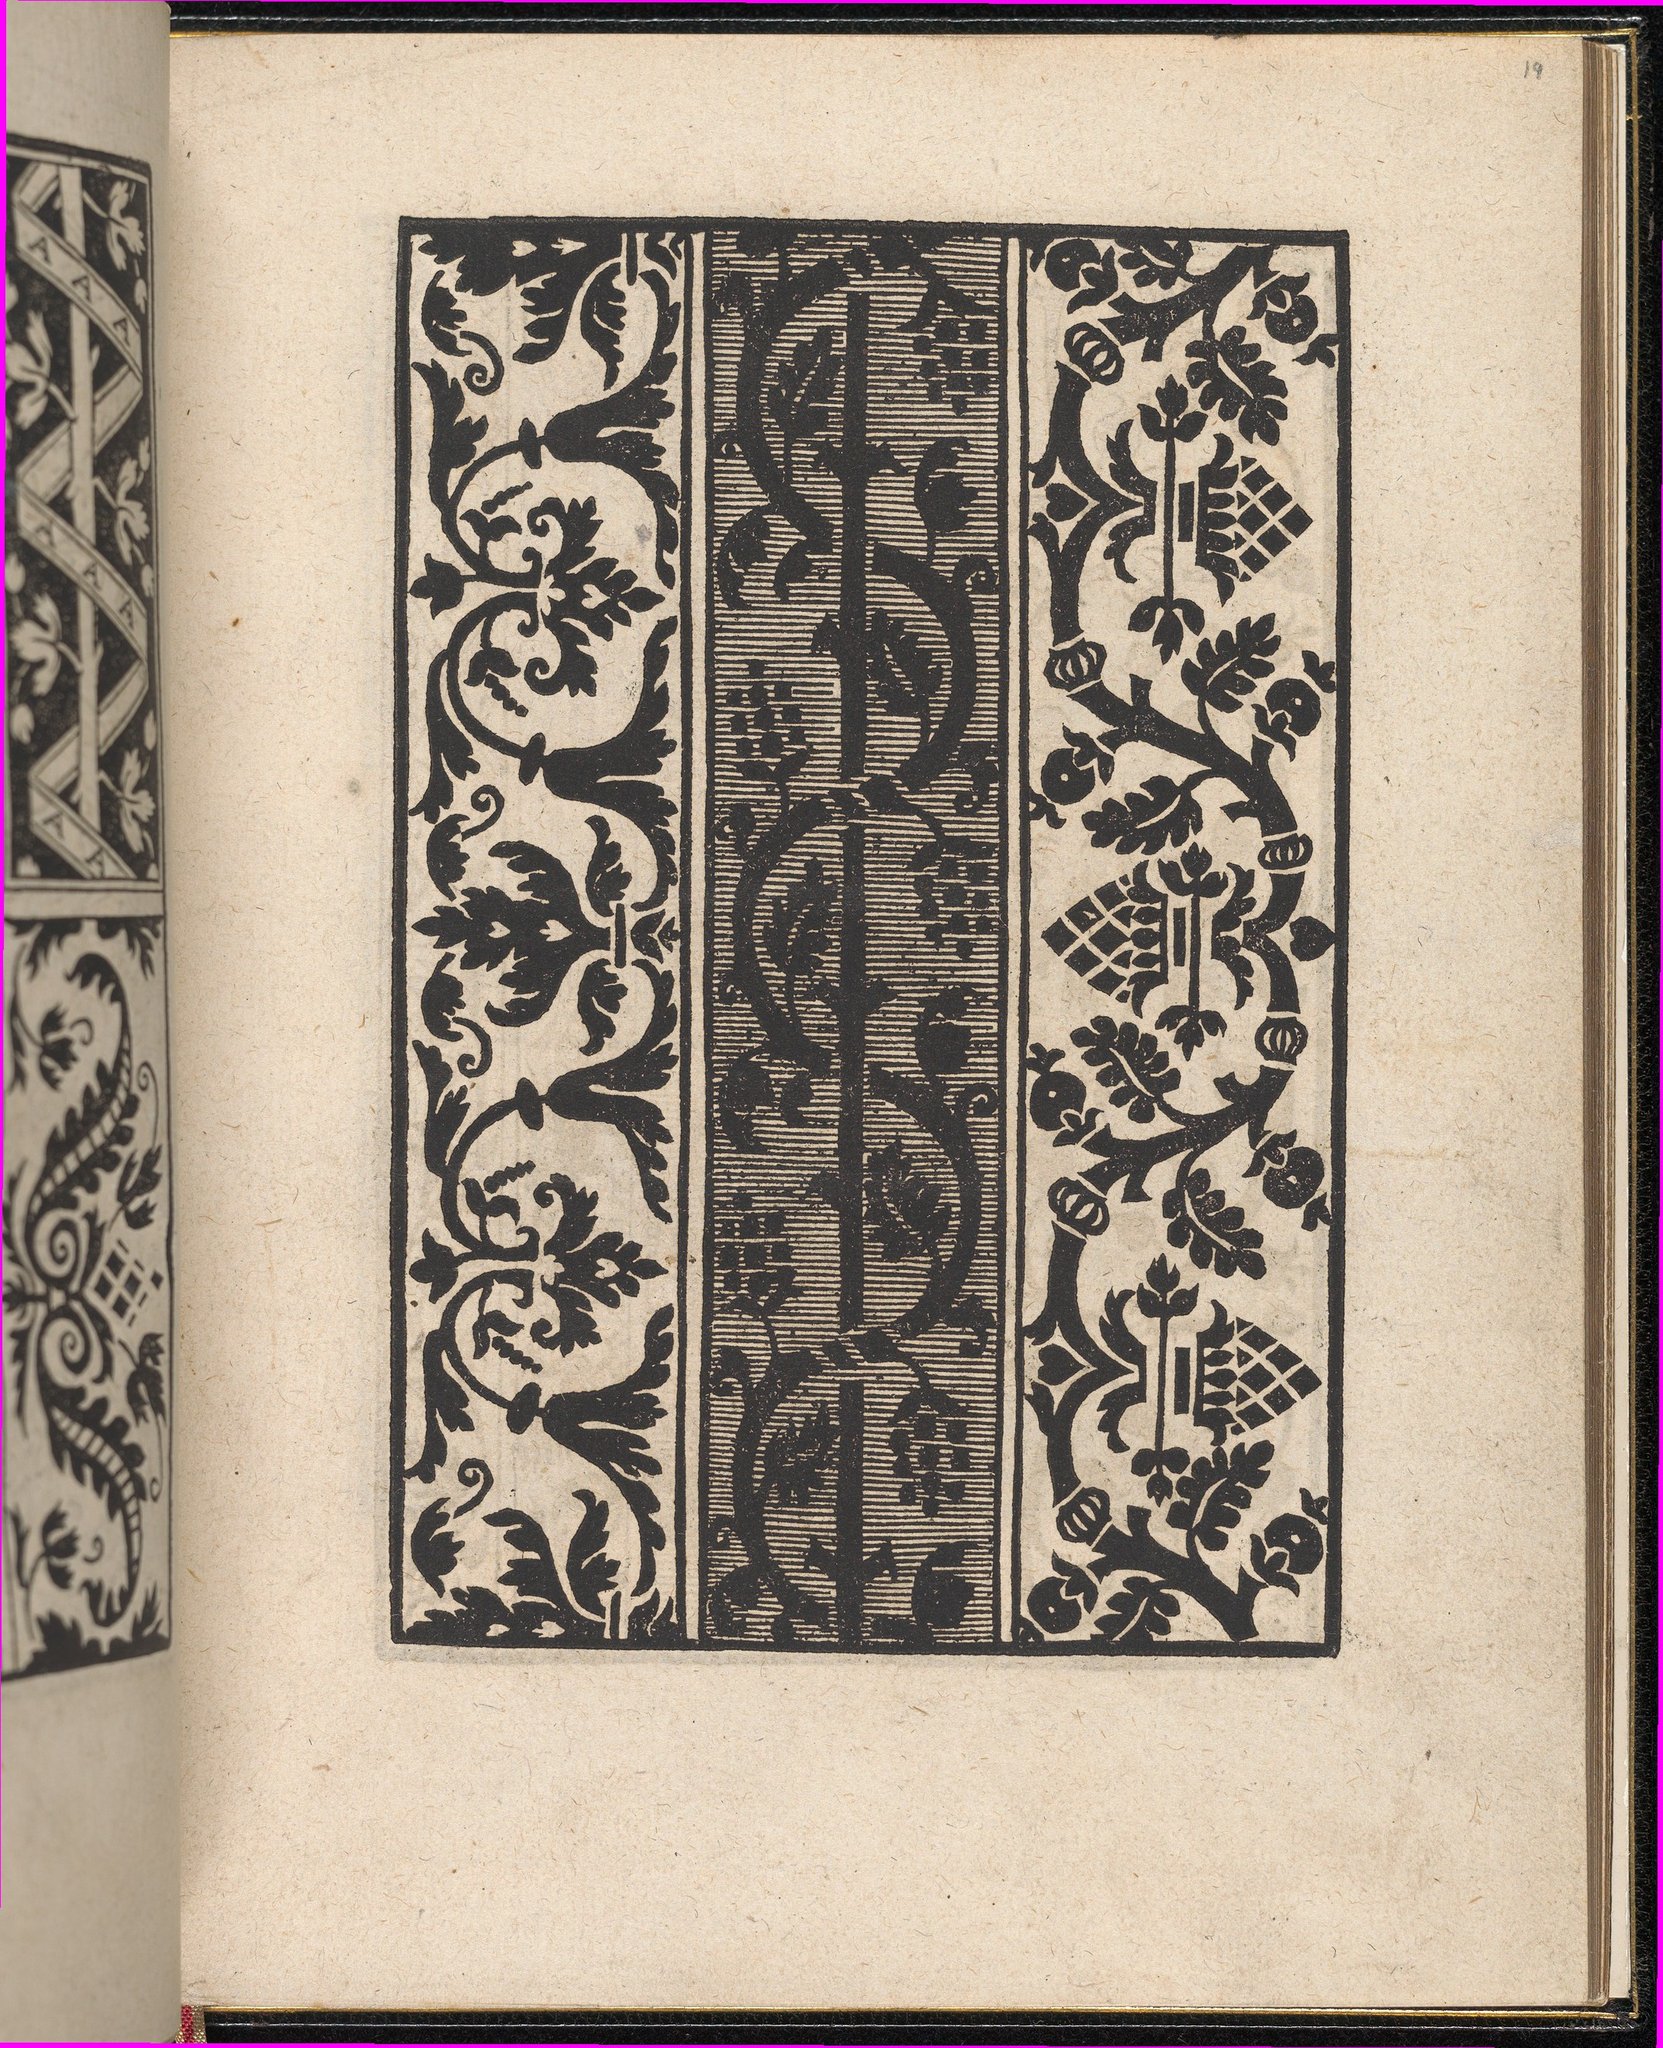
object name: book print ornament architecture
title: Page from Ein new kunstlich Modelbuch...(Page 19r)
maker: peter quentel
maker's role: publisher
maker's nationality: german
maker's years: 1500-1550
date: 1544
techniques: woodcut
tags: flowers